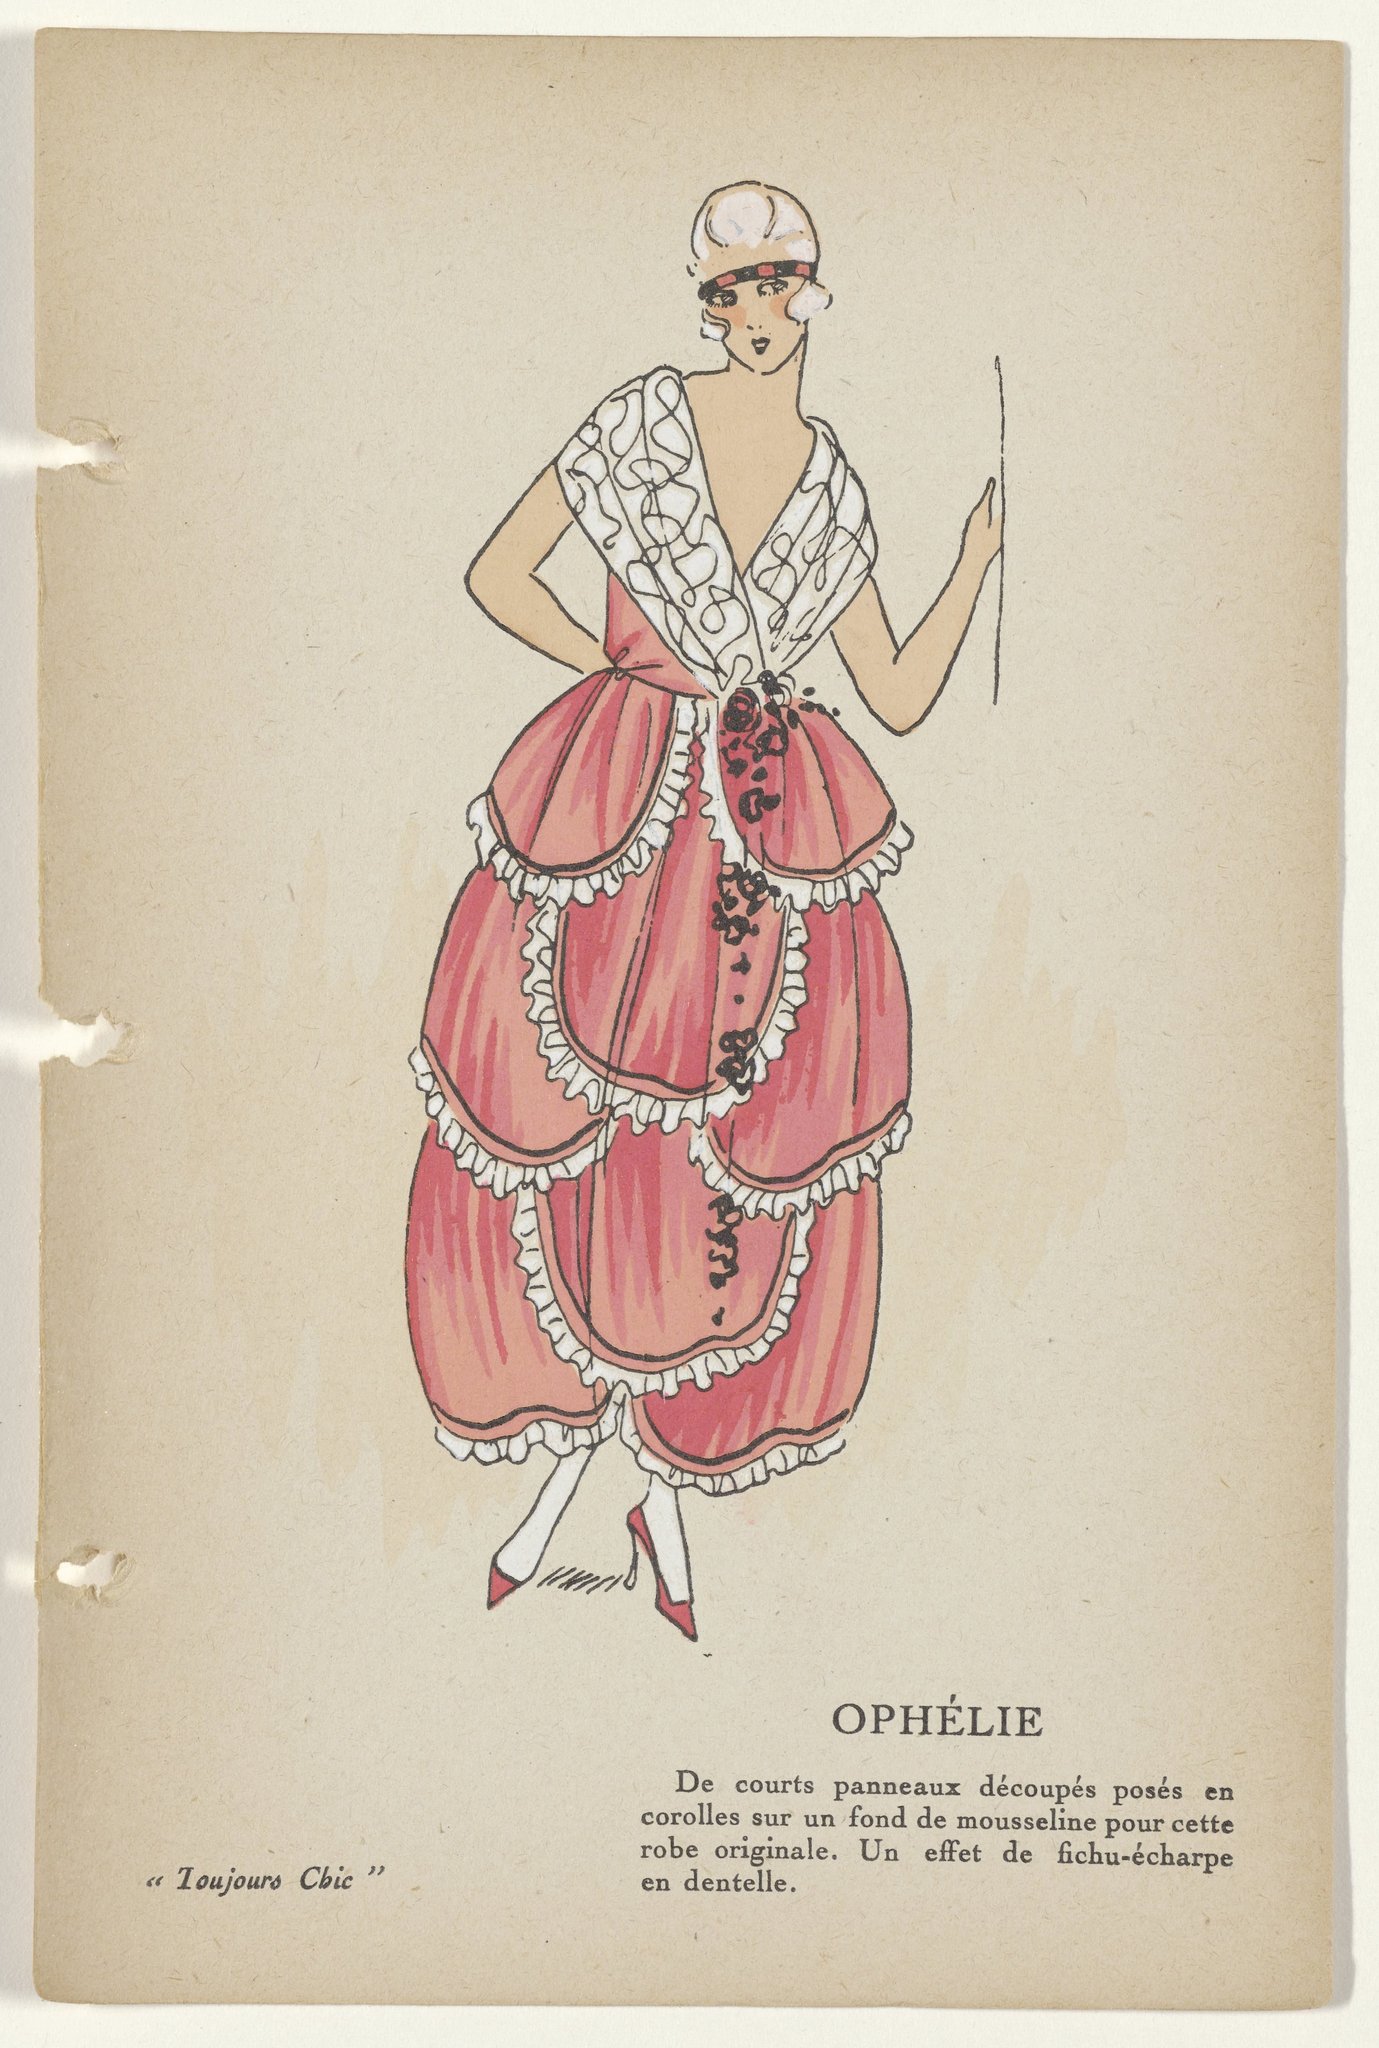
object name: titelprent, frontispice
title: Toujours Chic, Toilettes de Soirées, Hiver 1921-1922: Ophélie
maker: g-p. joumard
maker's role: publisher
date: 1921-1922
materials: paper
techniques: letterpress printing, pochoir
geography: paris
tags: fashion plates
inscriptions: date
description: Prent uit Catalogus "Toujours Chic" waarin een overzicht van de wintermode 1921-1922 in 80 prentjes in pochoir techniek.